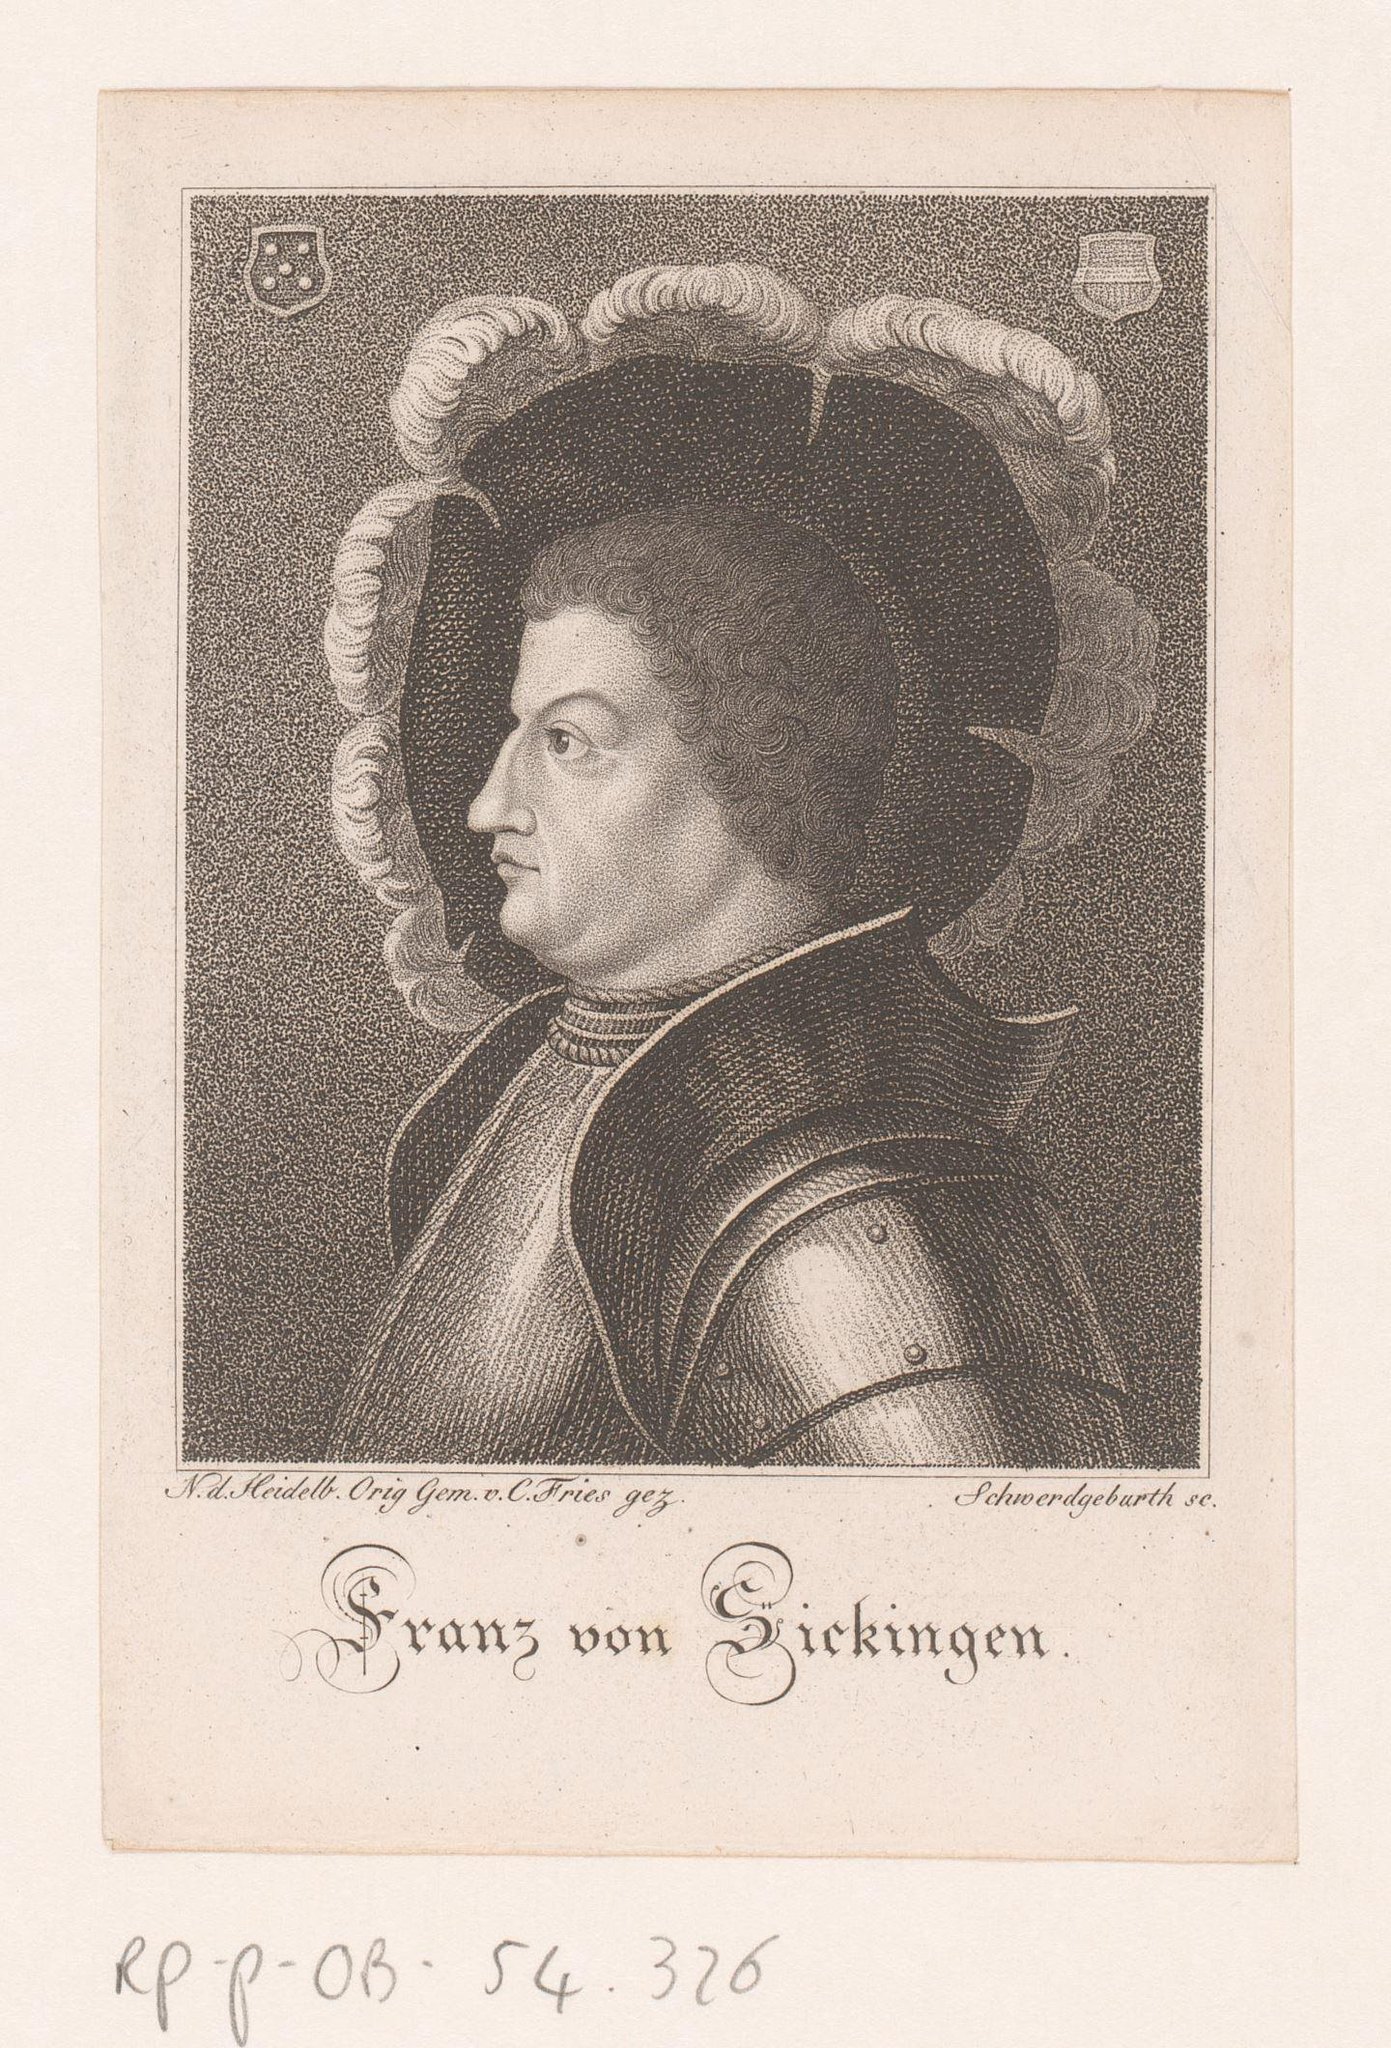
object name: print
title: Portret van Franz von Sickingen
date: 1795-1878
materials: paper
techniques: stippling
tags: historical persons, armorial bearing, heraldry